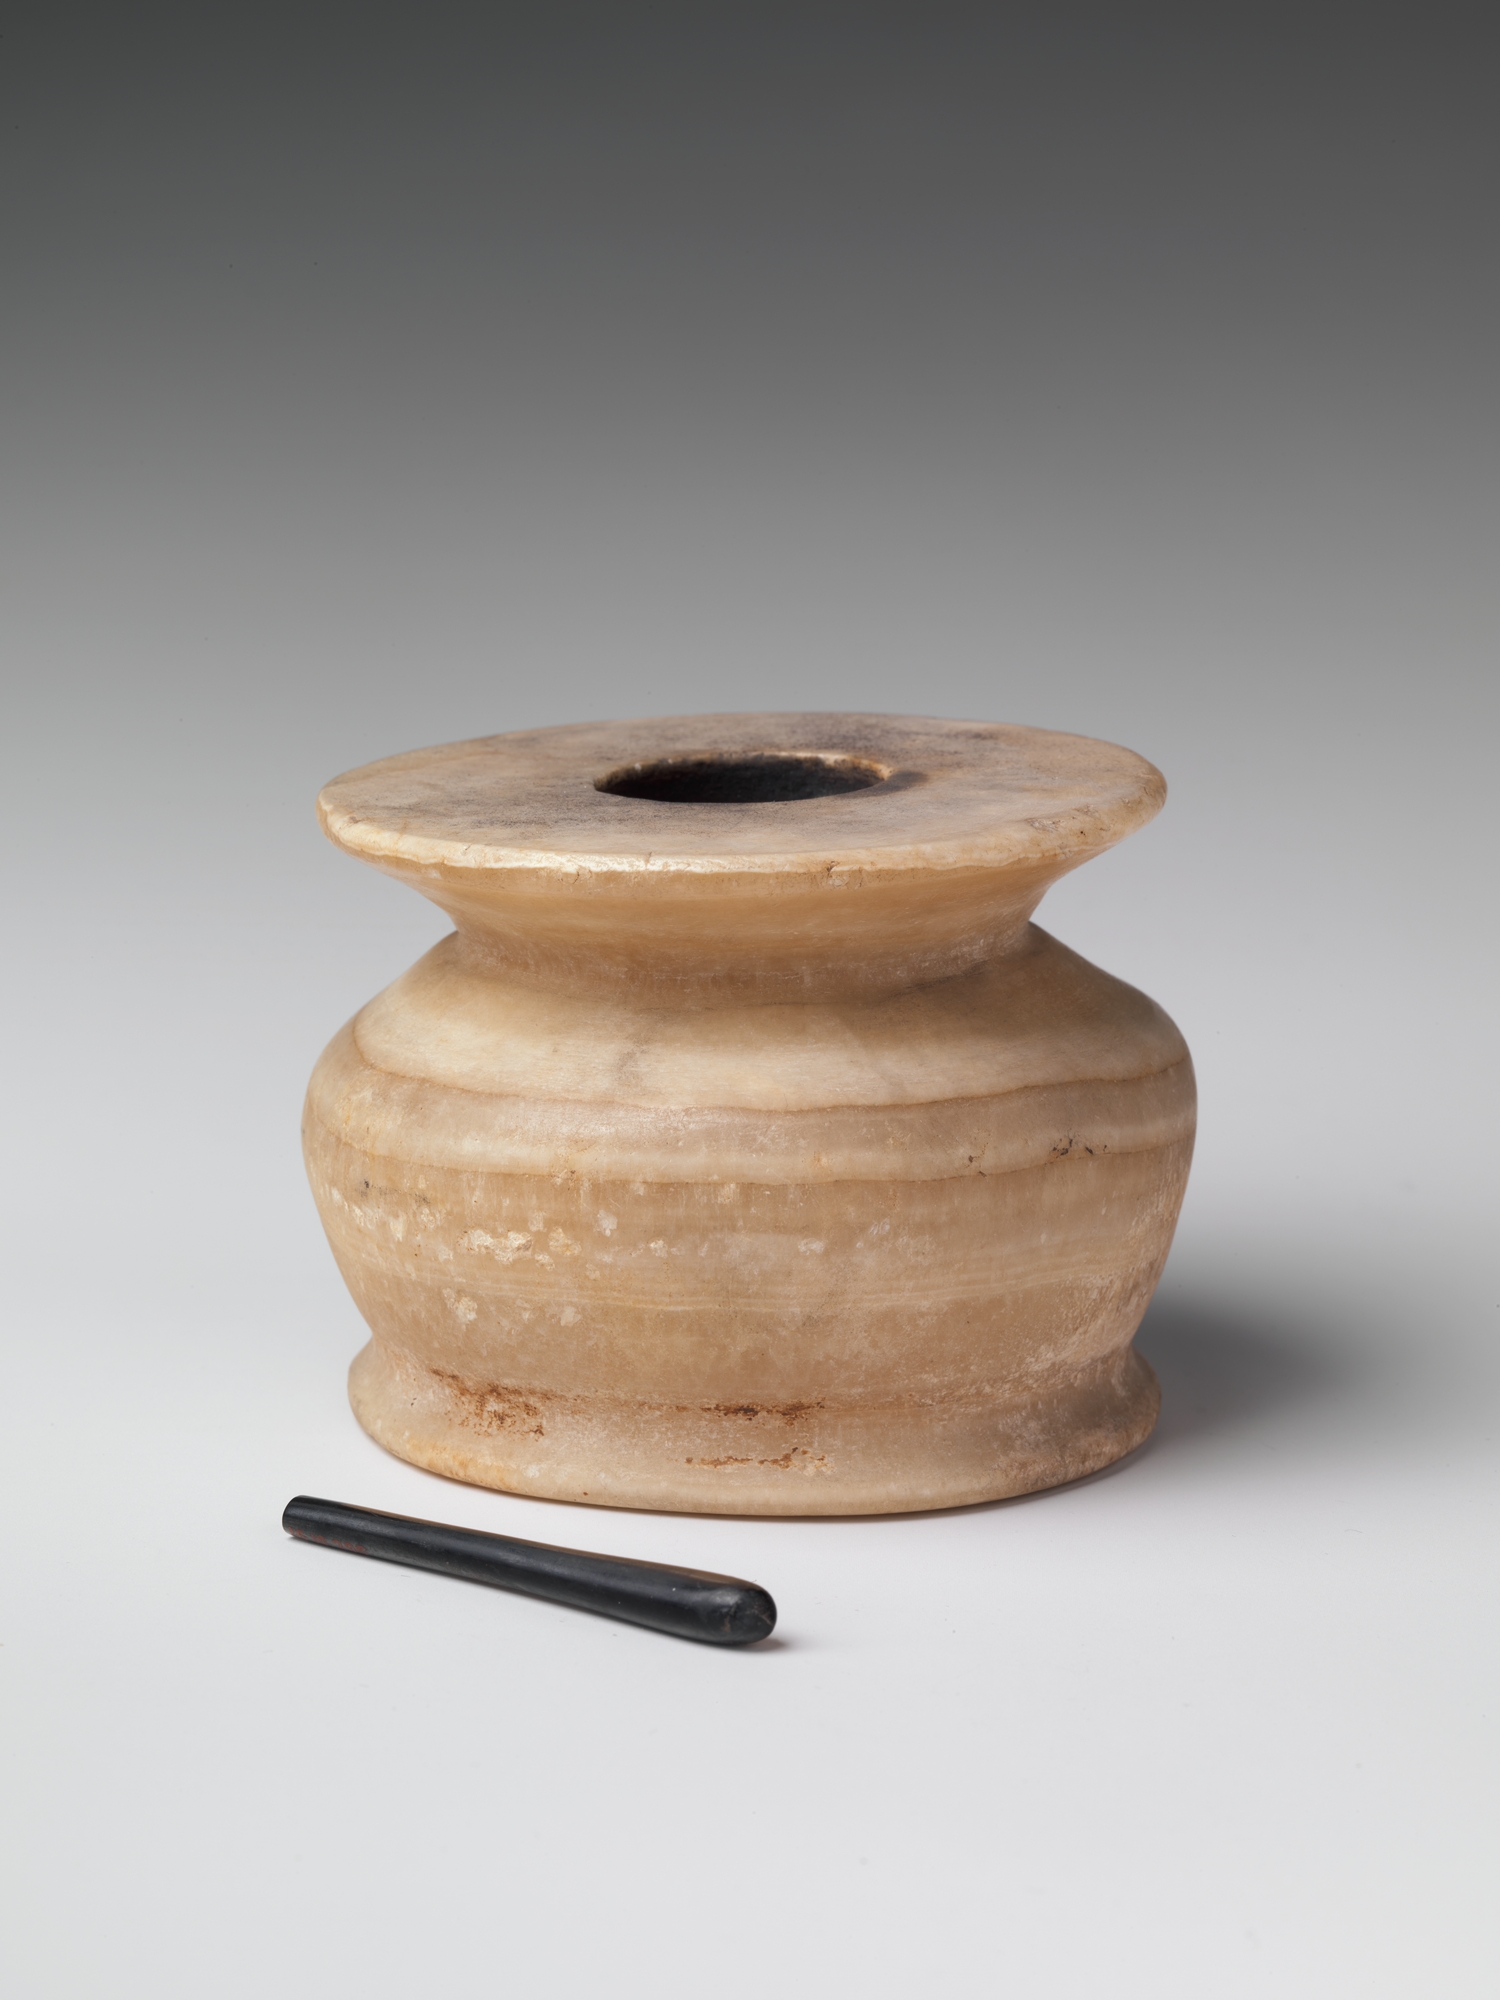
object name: kohl jar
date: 1635-1458 BCE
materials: stone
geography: egypt